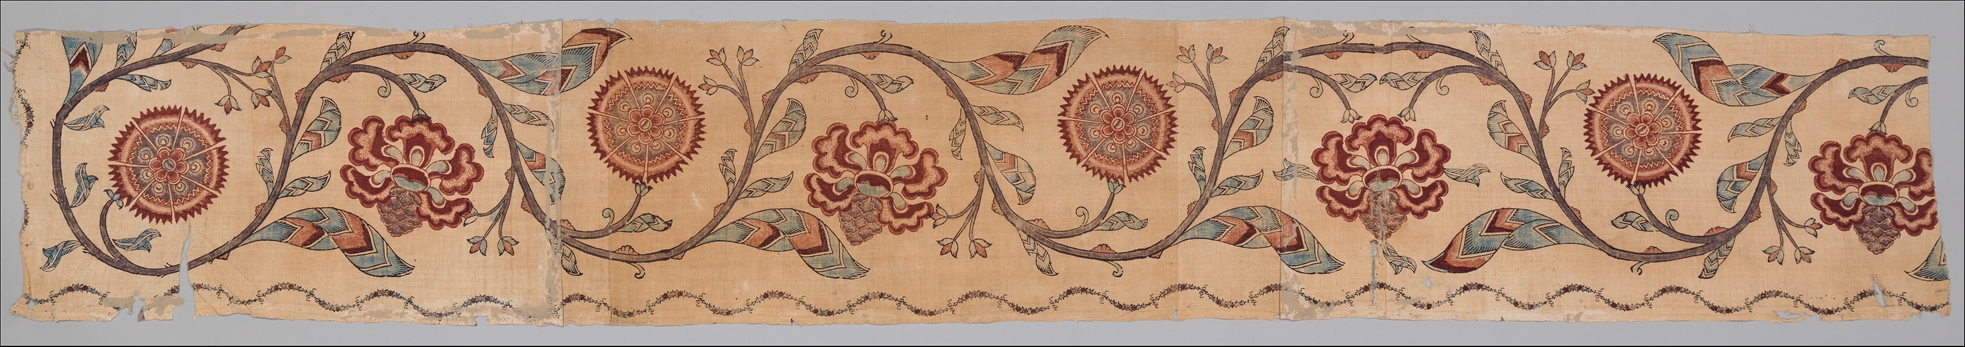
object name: textile fragment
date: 1701-1800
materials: cotton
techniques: painting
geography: india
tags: flowers